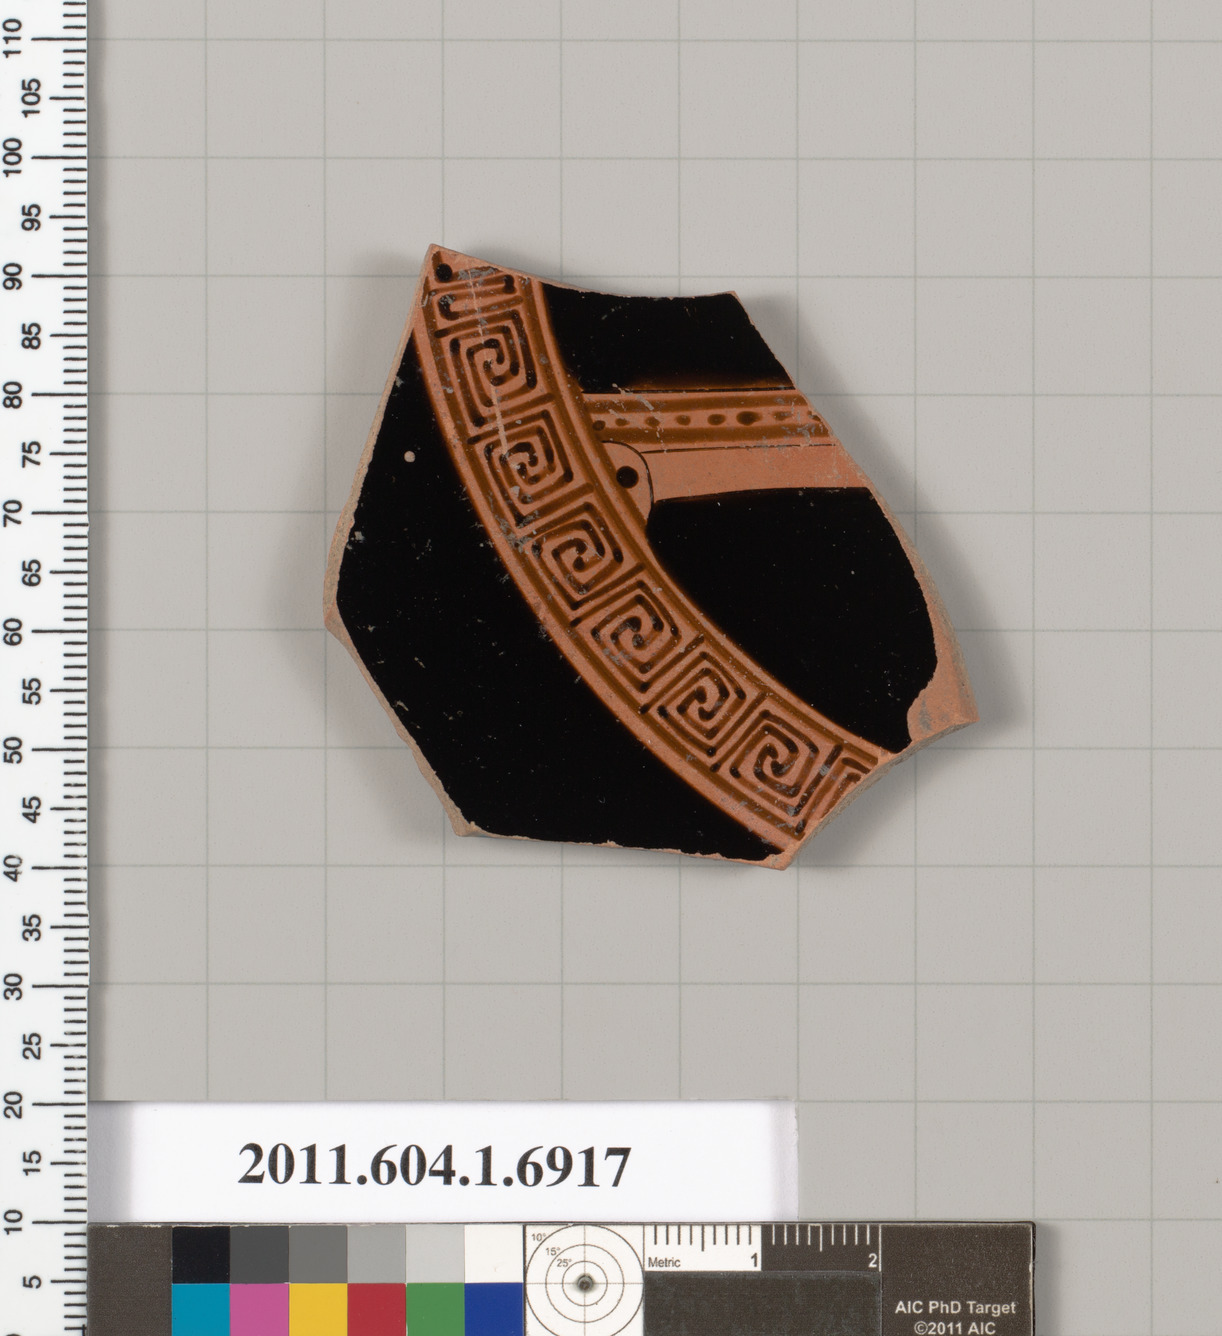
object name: kylix fragment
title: Terracotta fragment of a kylix (drinking cup)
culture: greek, attic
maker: brygan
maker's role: artist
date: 490-470 BCE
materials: terracotta